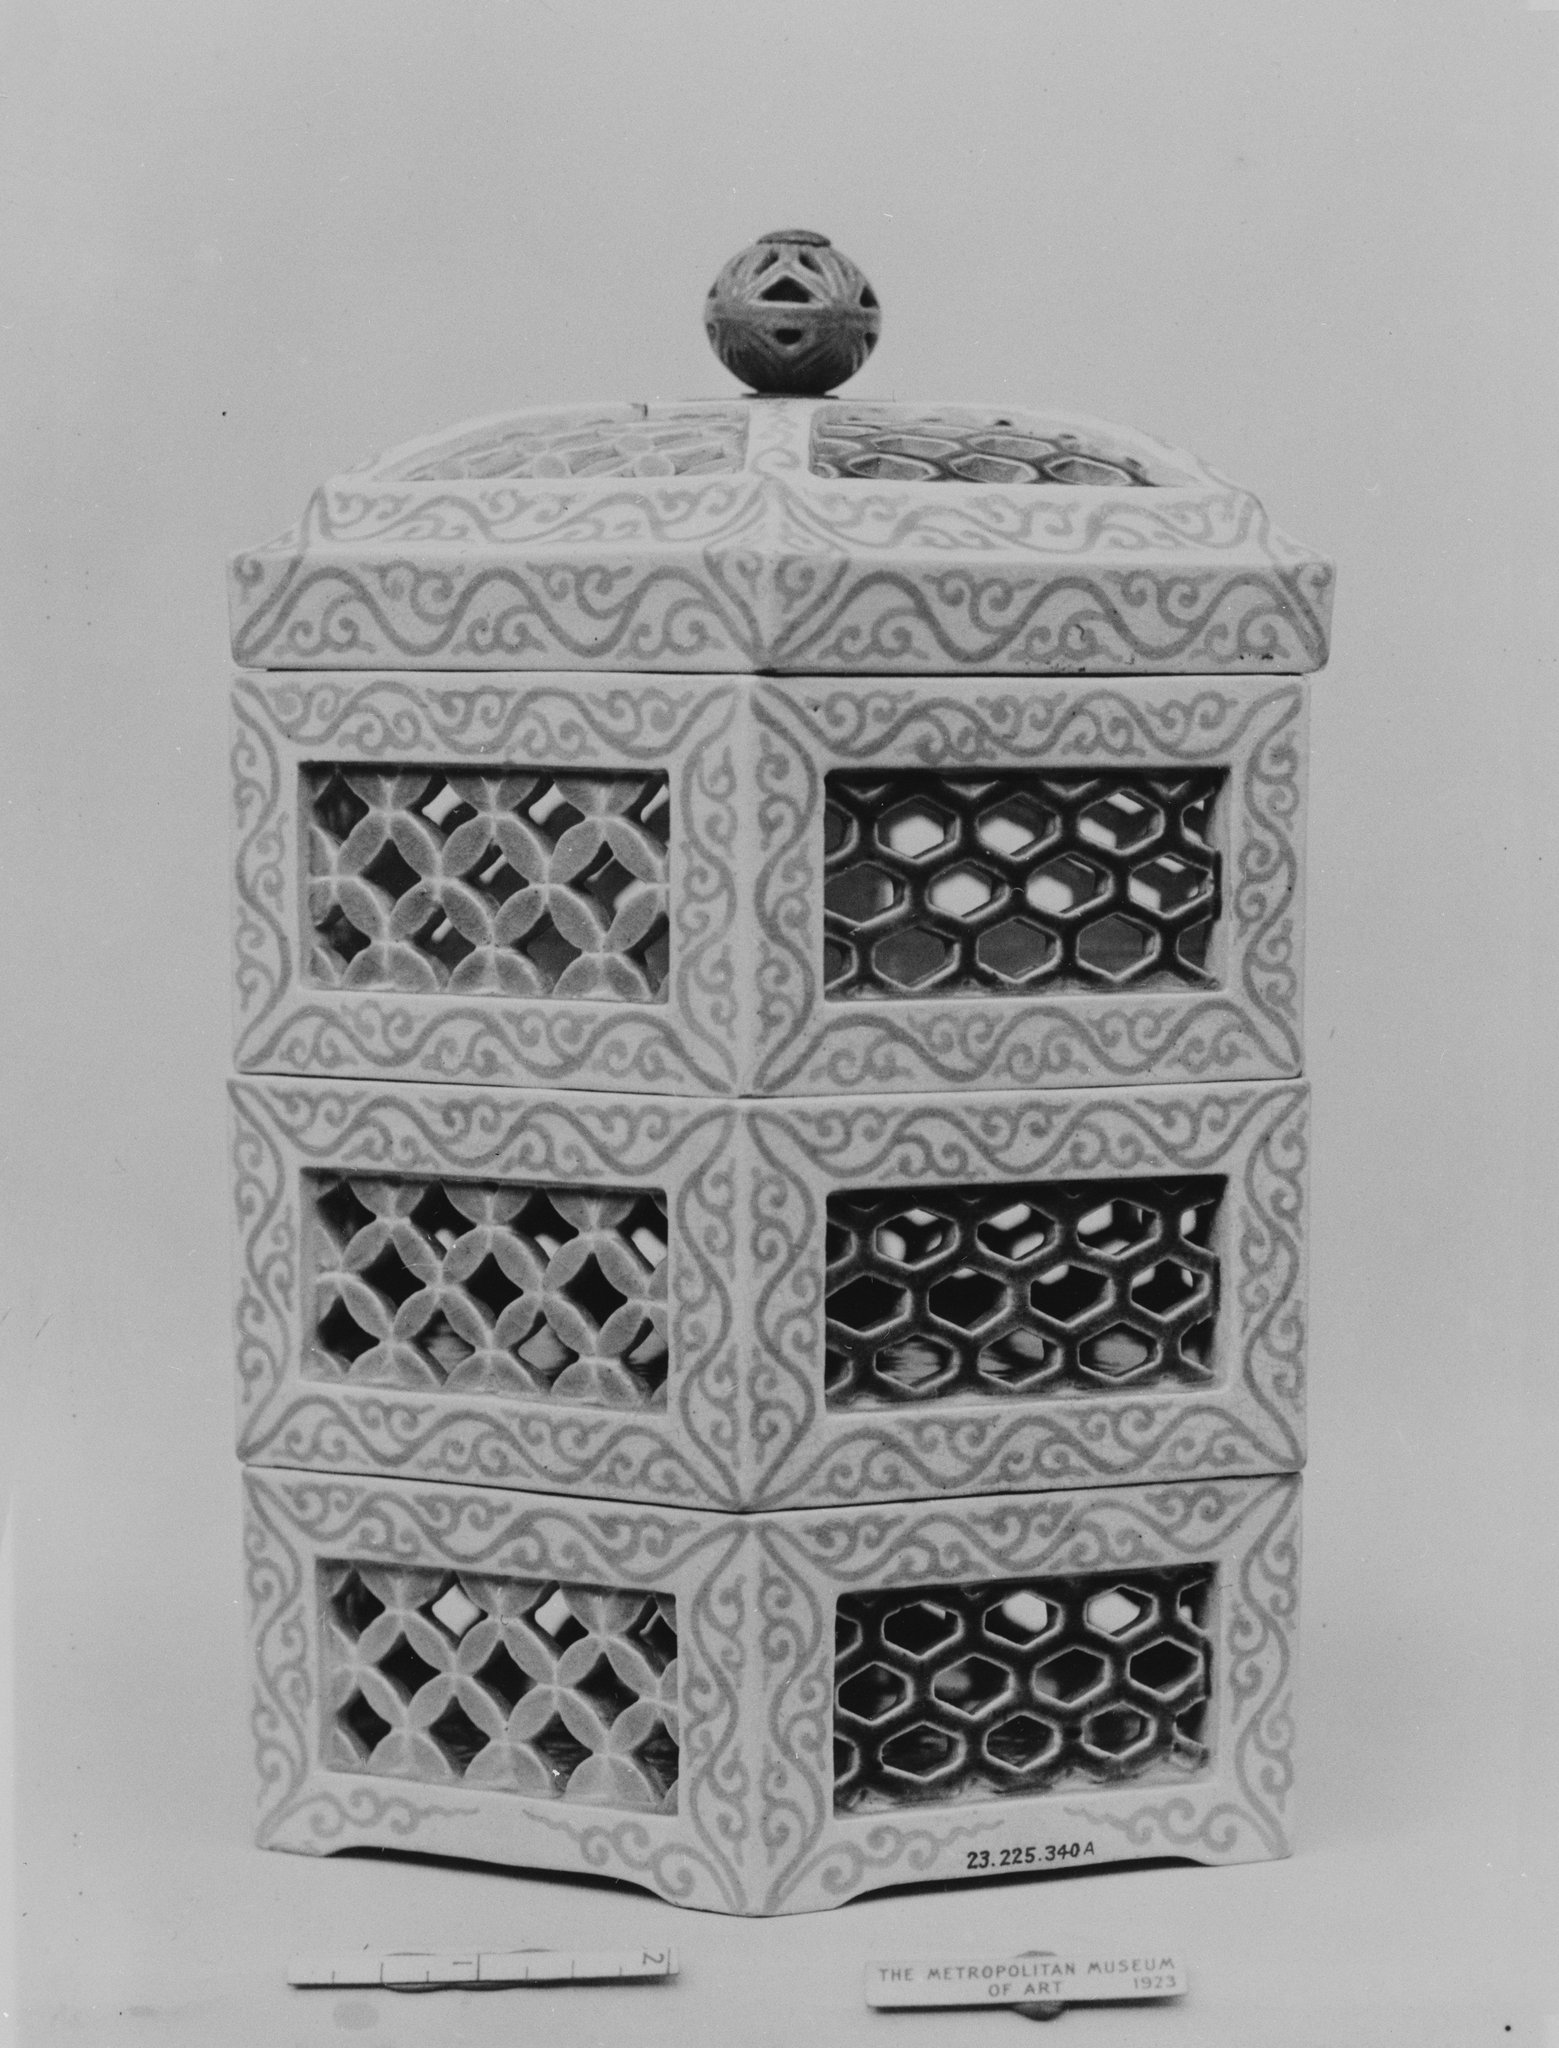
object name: cake box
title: Cake Box in Three Tiers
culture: japanese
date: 1830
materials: faience